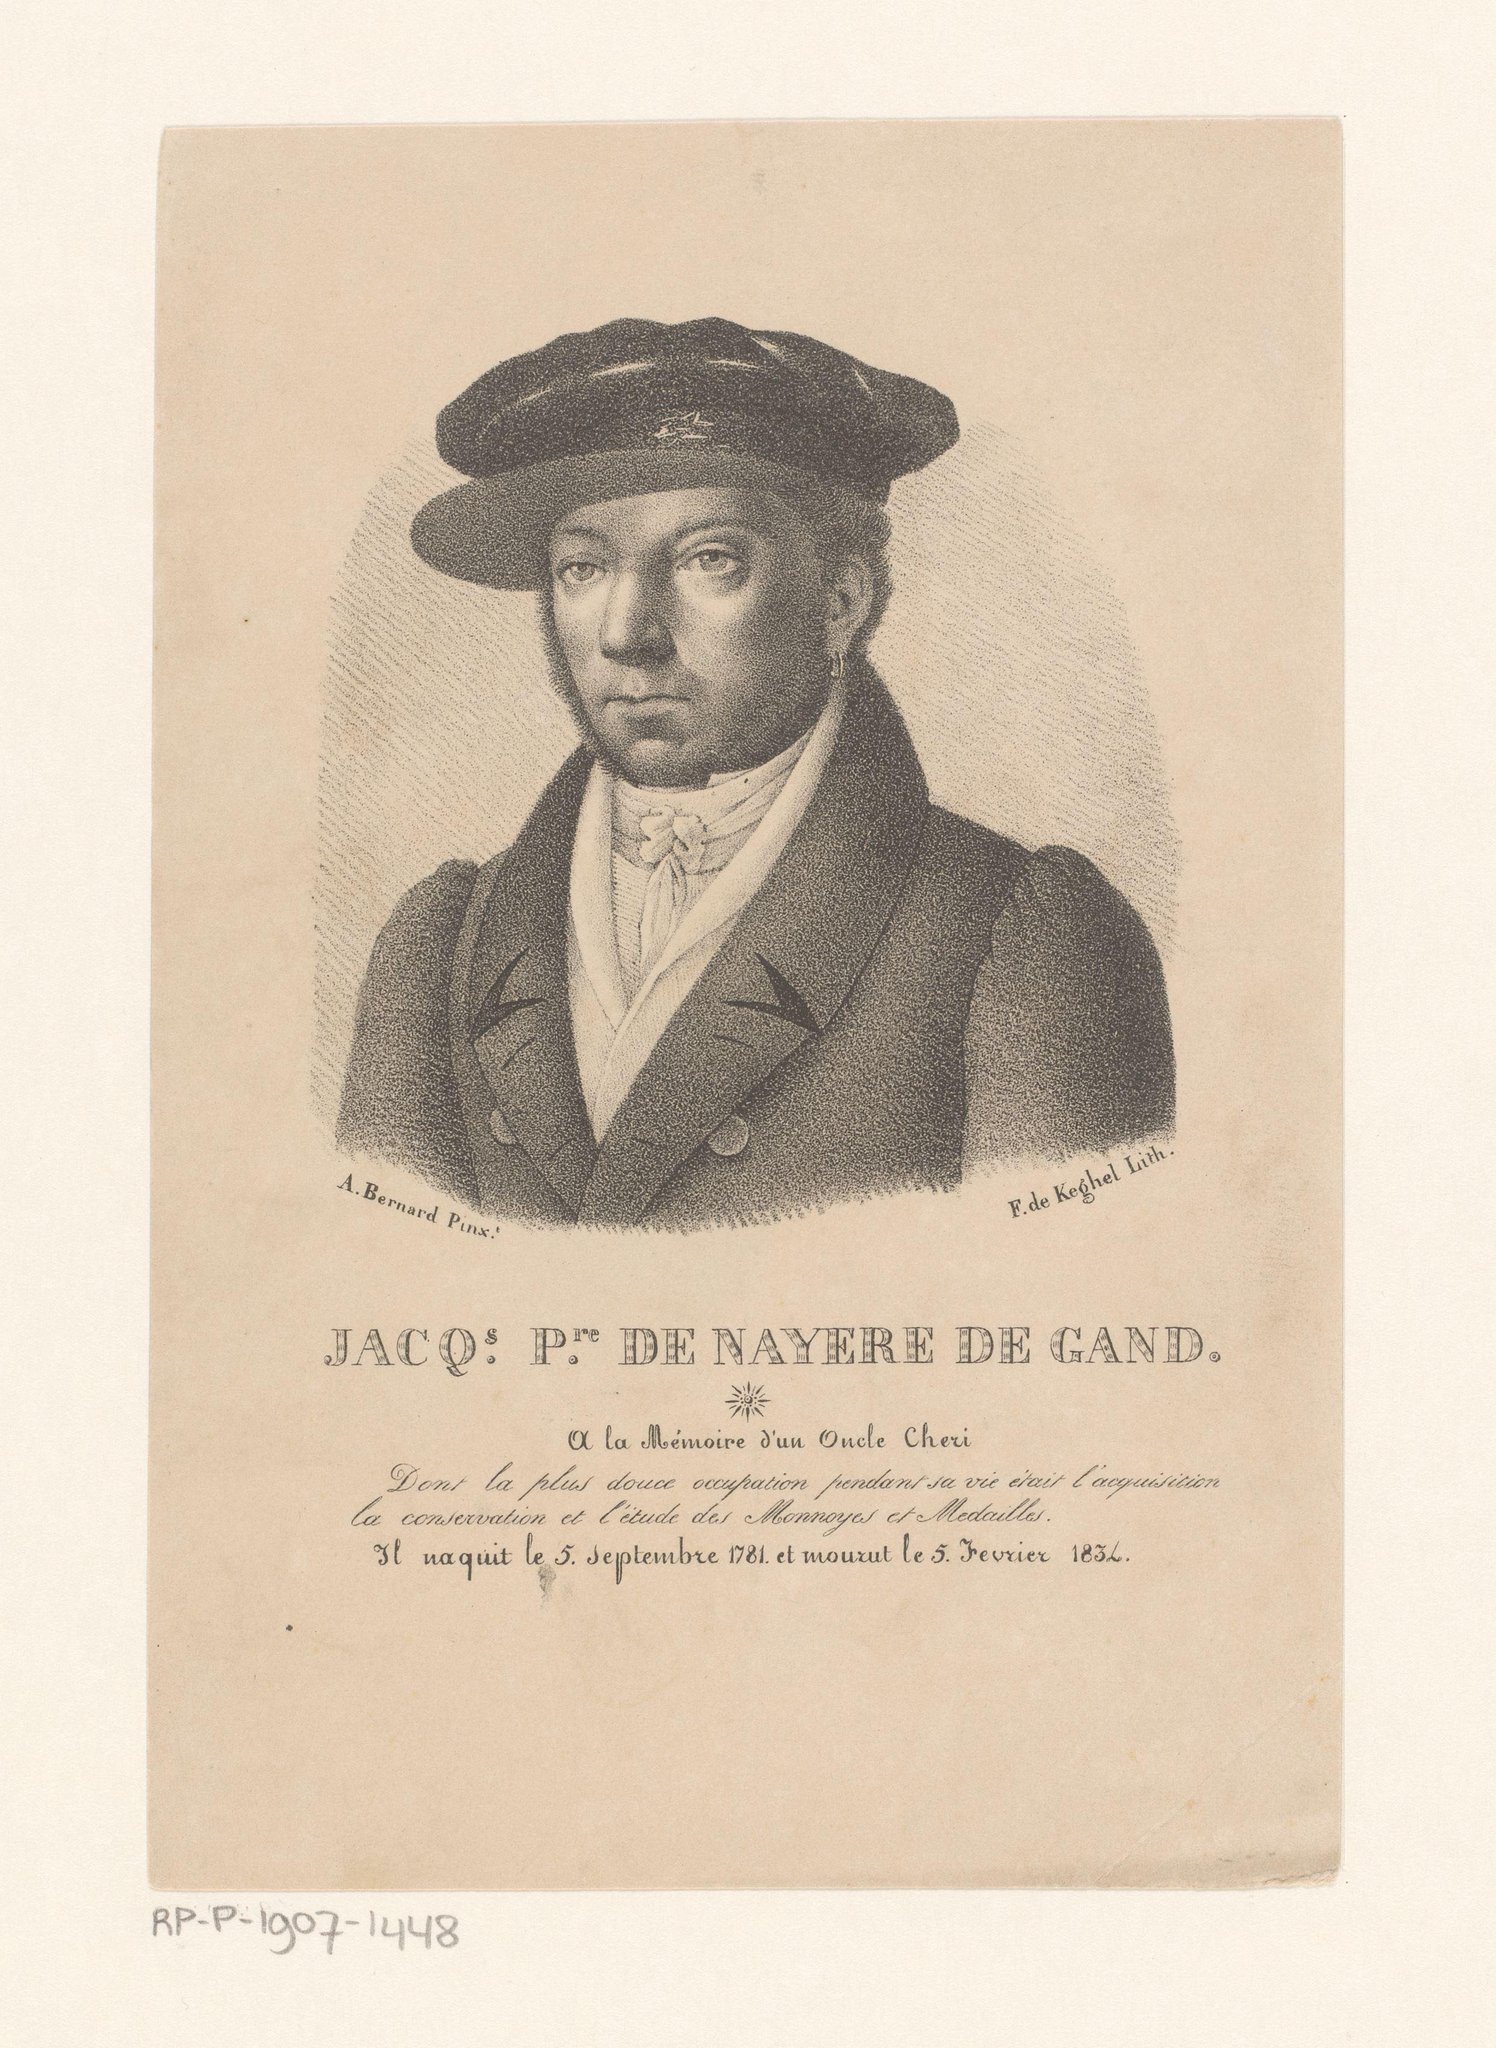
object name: print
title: Jacq.s P.re de Nayere de Gand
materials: paper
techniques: lithograph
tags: historical persons, medal (considered as a piece of sculpture, regardless of its specific function), coin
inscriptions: collector's mark: Lugt 2228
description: Portret van Jacques Pierre de Nayere, een loodgieter uit Gent, en verzamelaar van munten en penningen.